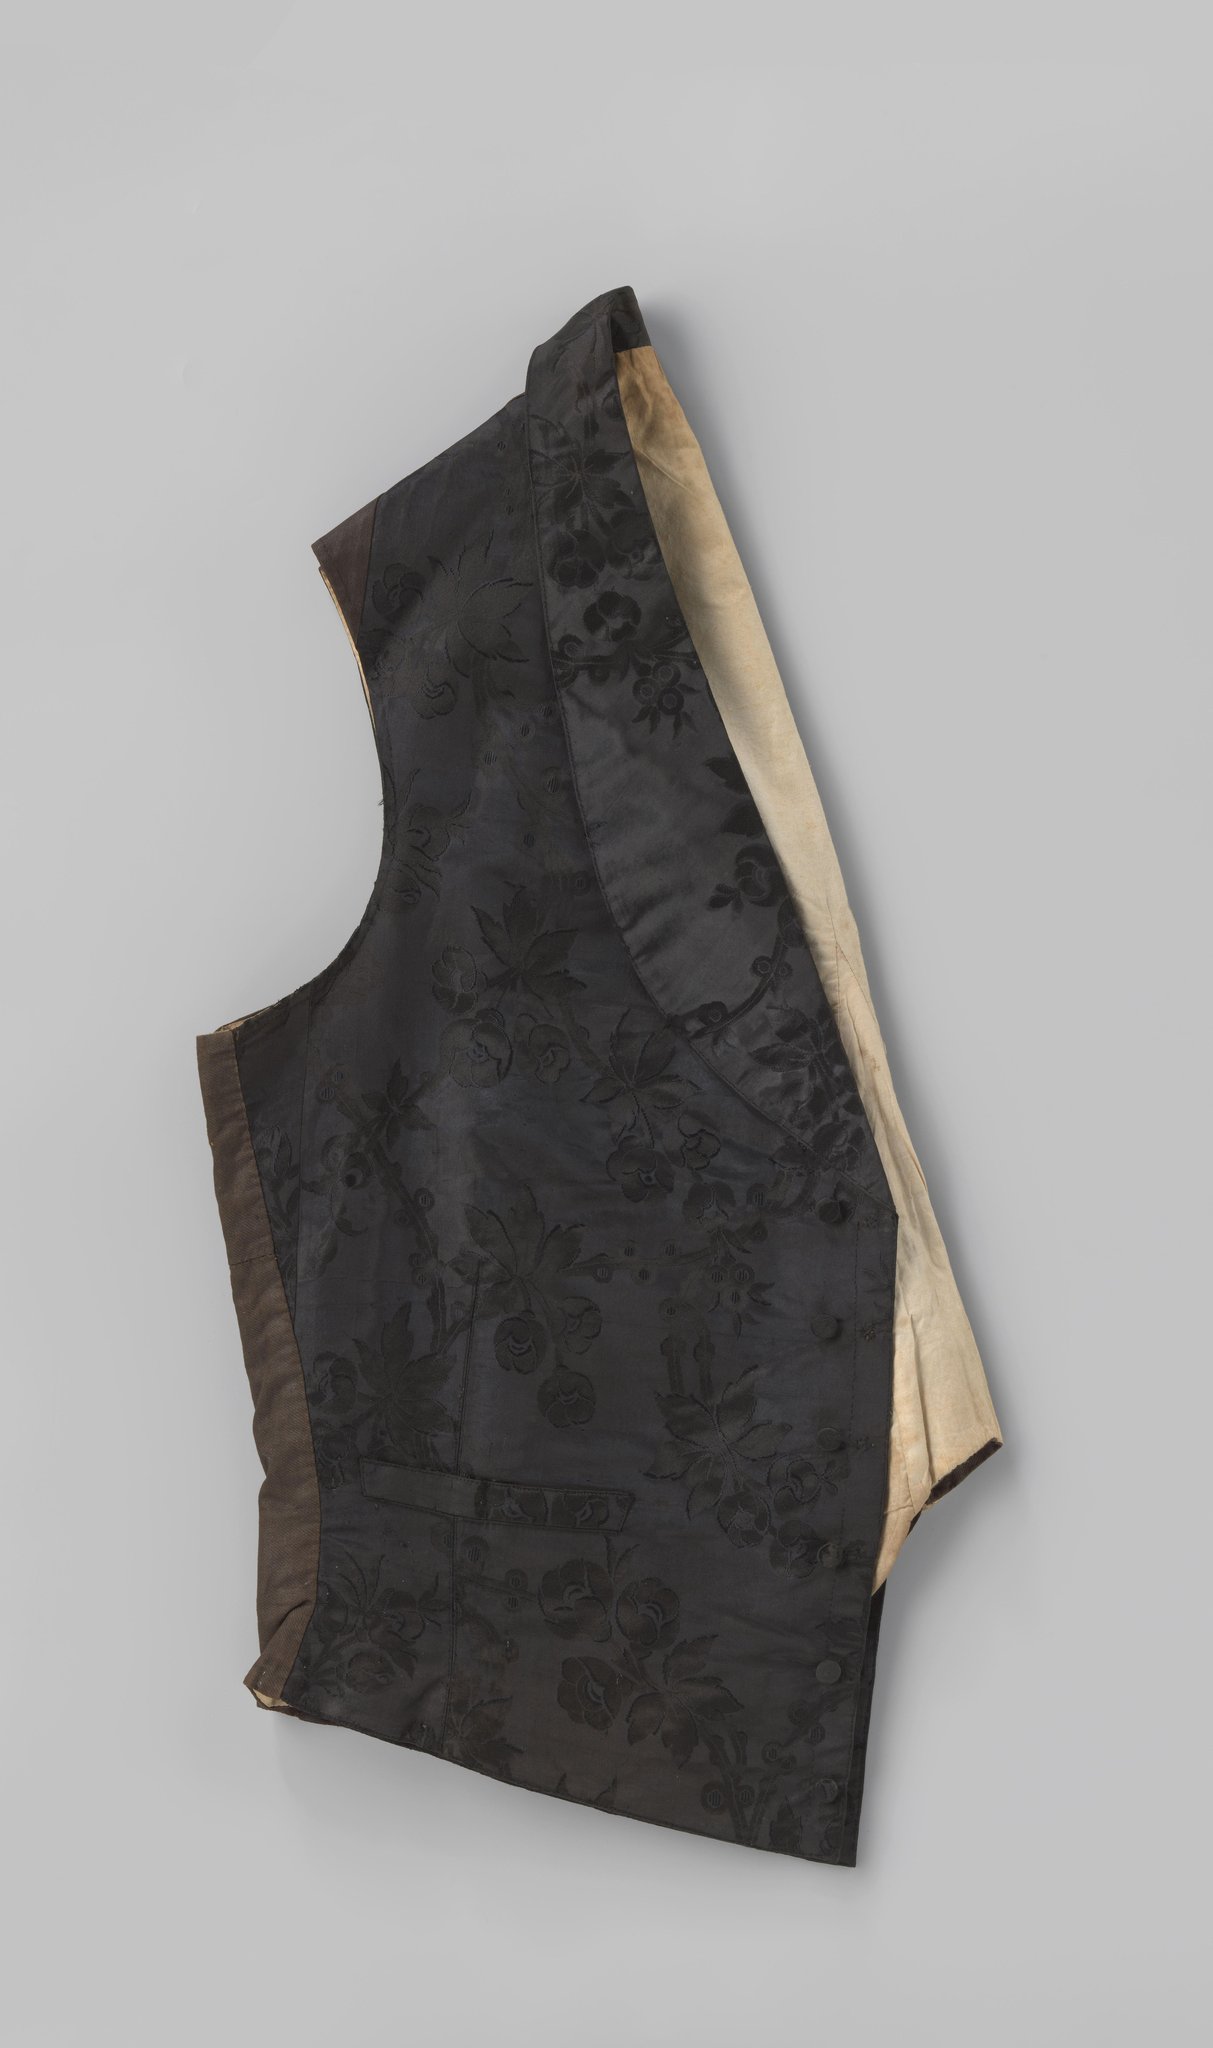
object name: main garment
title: Vest van zwarte zijdedamast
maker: Anonymous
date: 1835-1850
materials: silk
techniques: damask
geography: netherlands